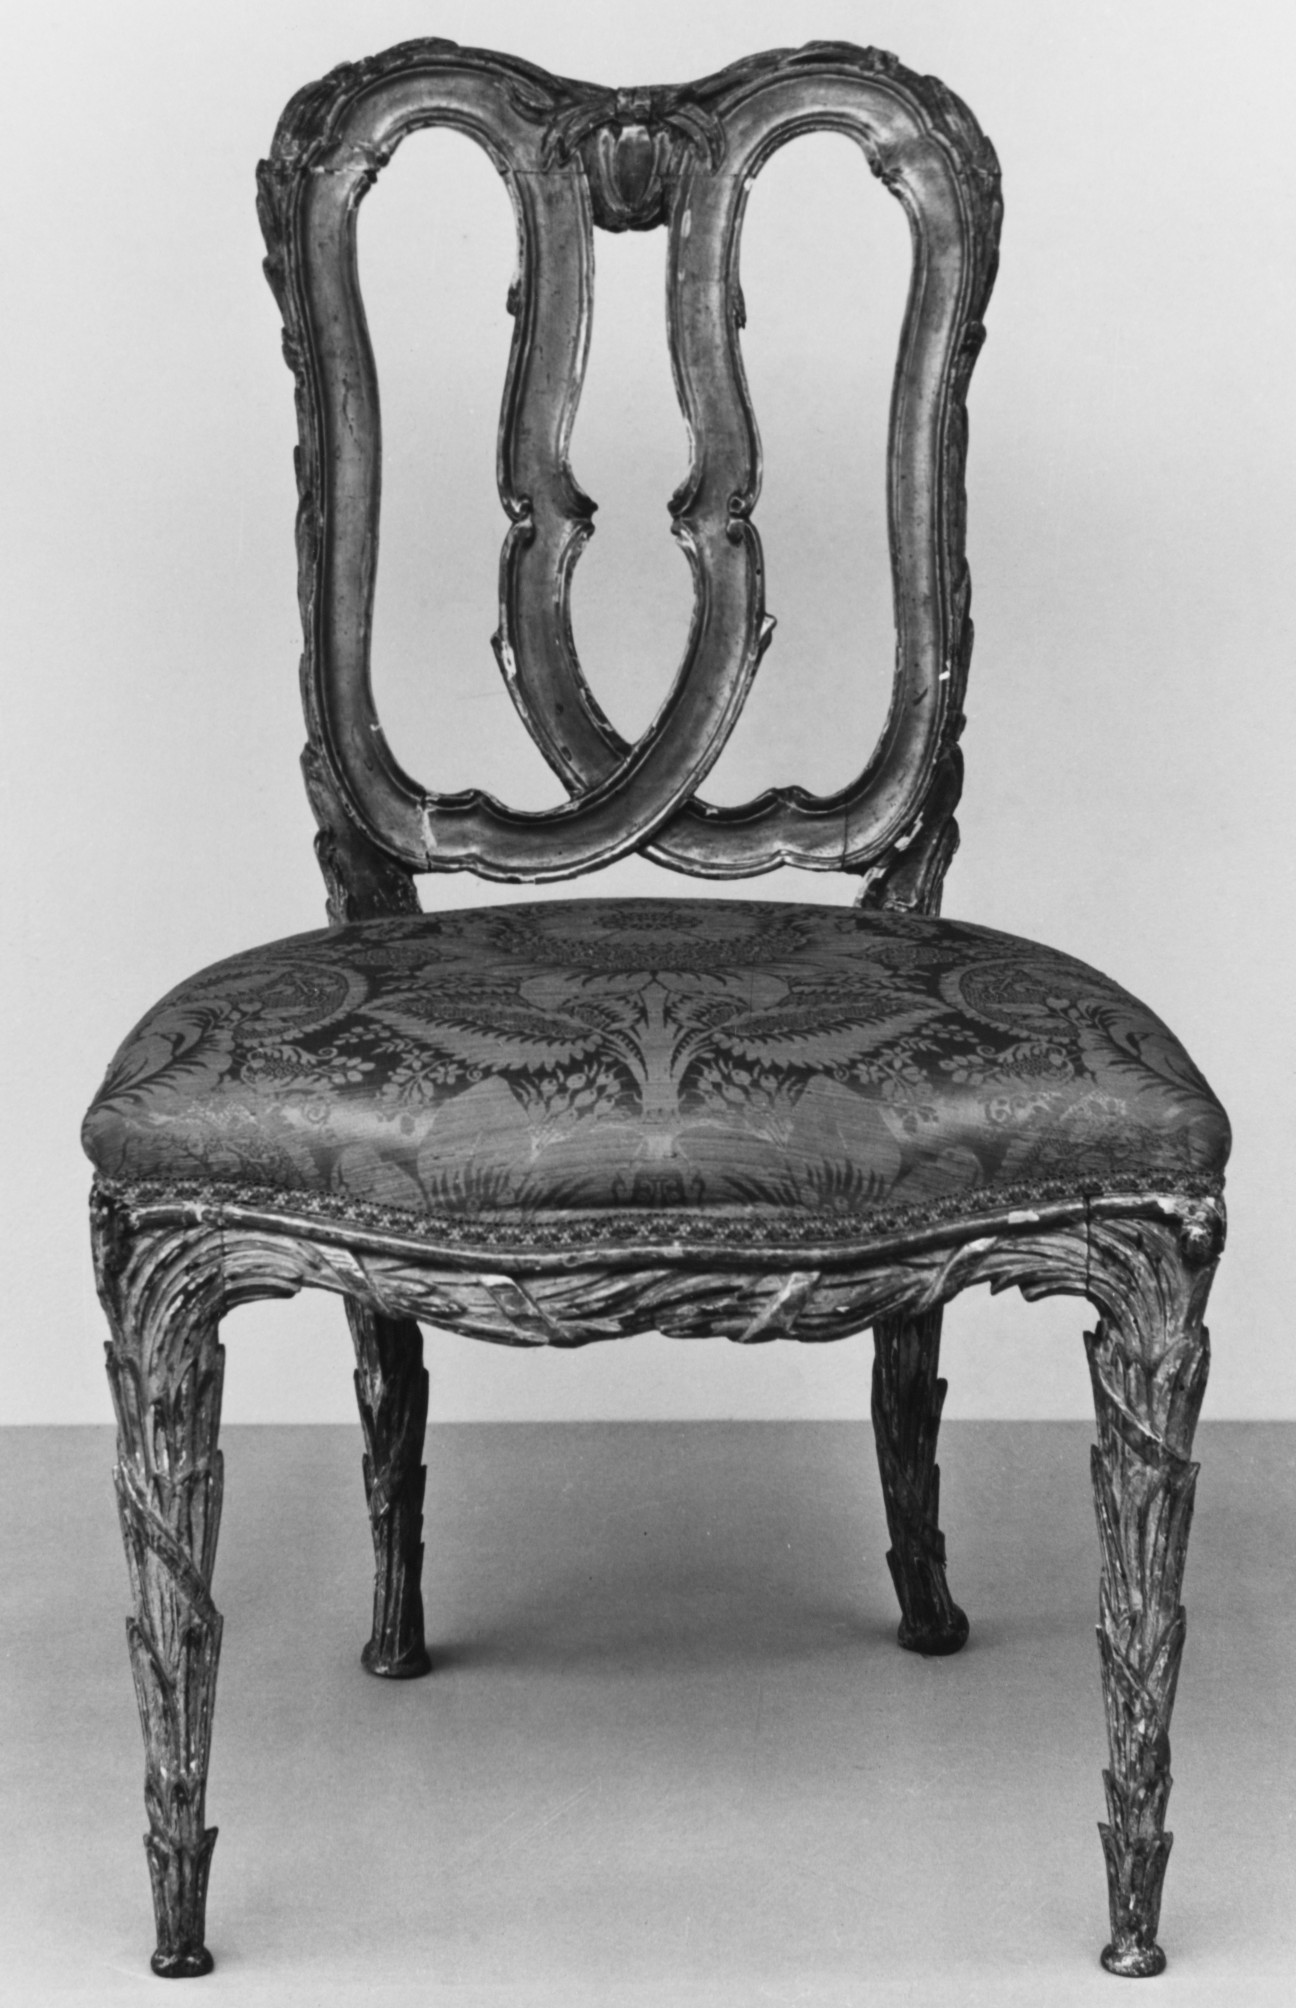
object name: side chair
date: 1751-1775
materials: wood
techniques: damask, gilding, painting